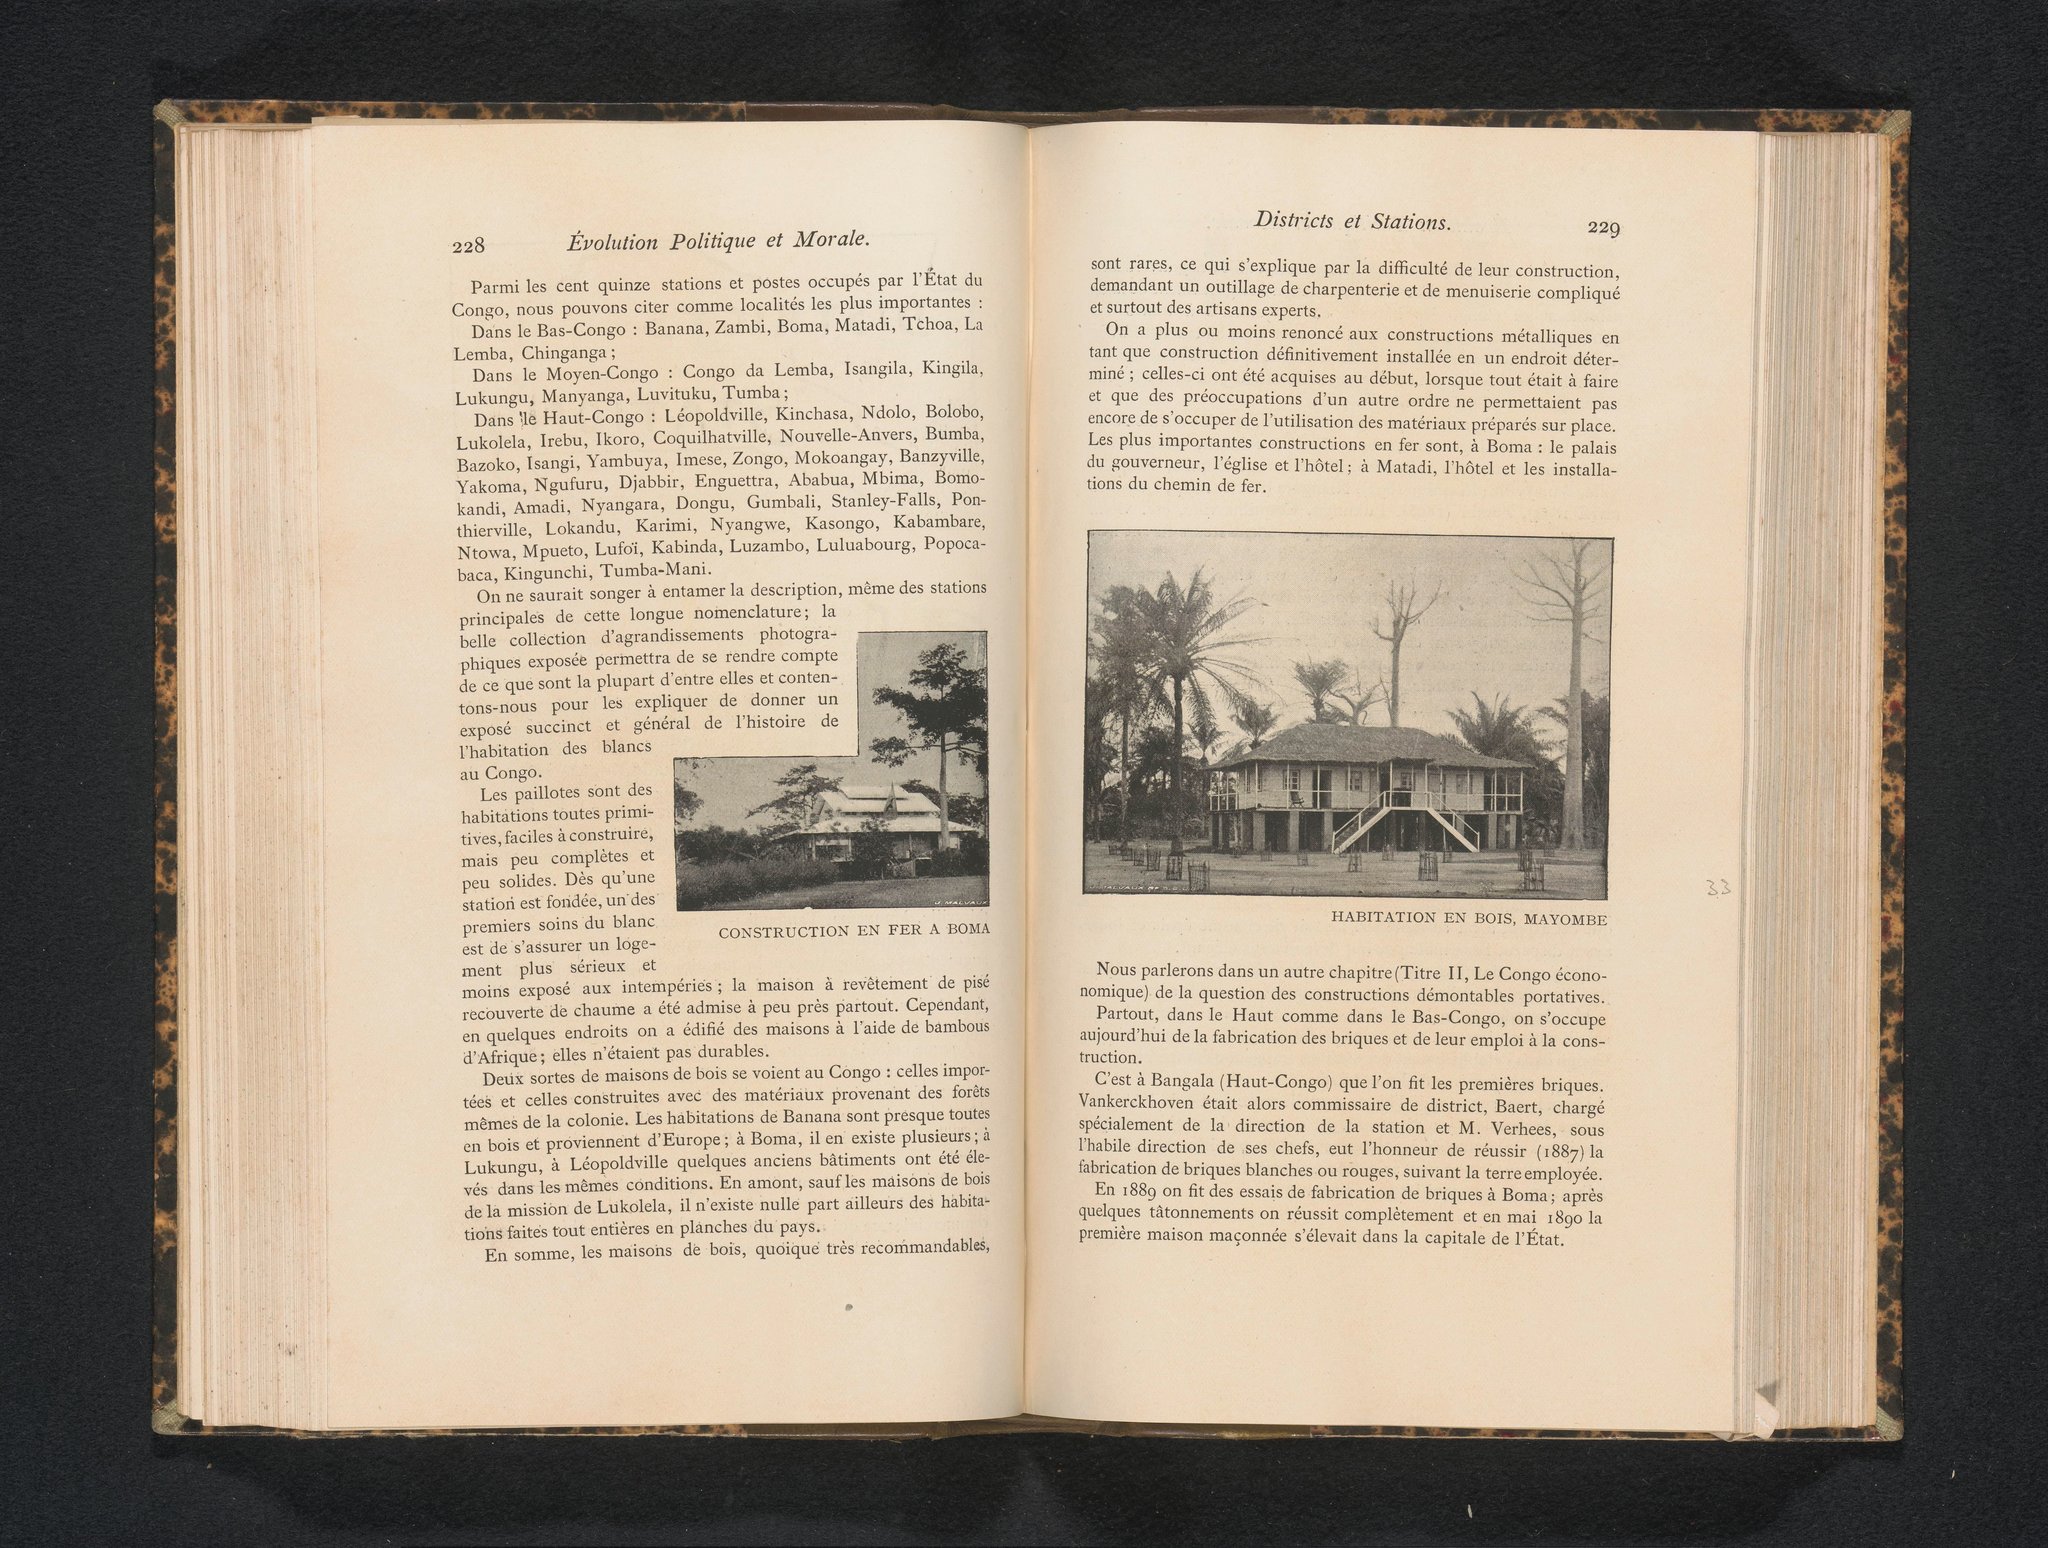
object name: page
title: Gezicht op een gebouw in Boma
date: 1887-1892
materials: paper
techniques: autotype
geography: congo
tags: façade (of house or building)